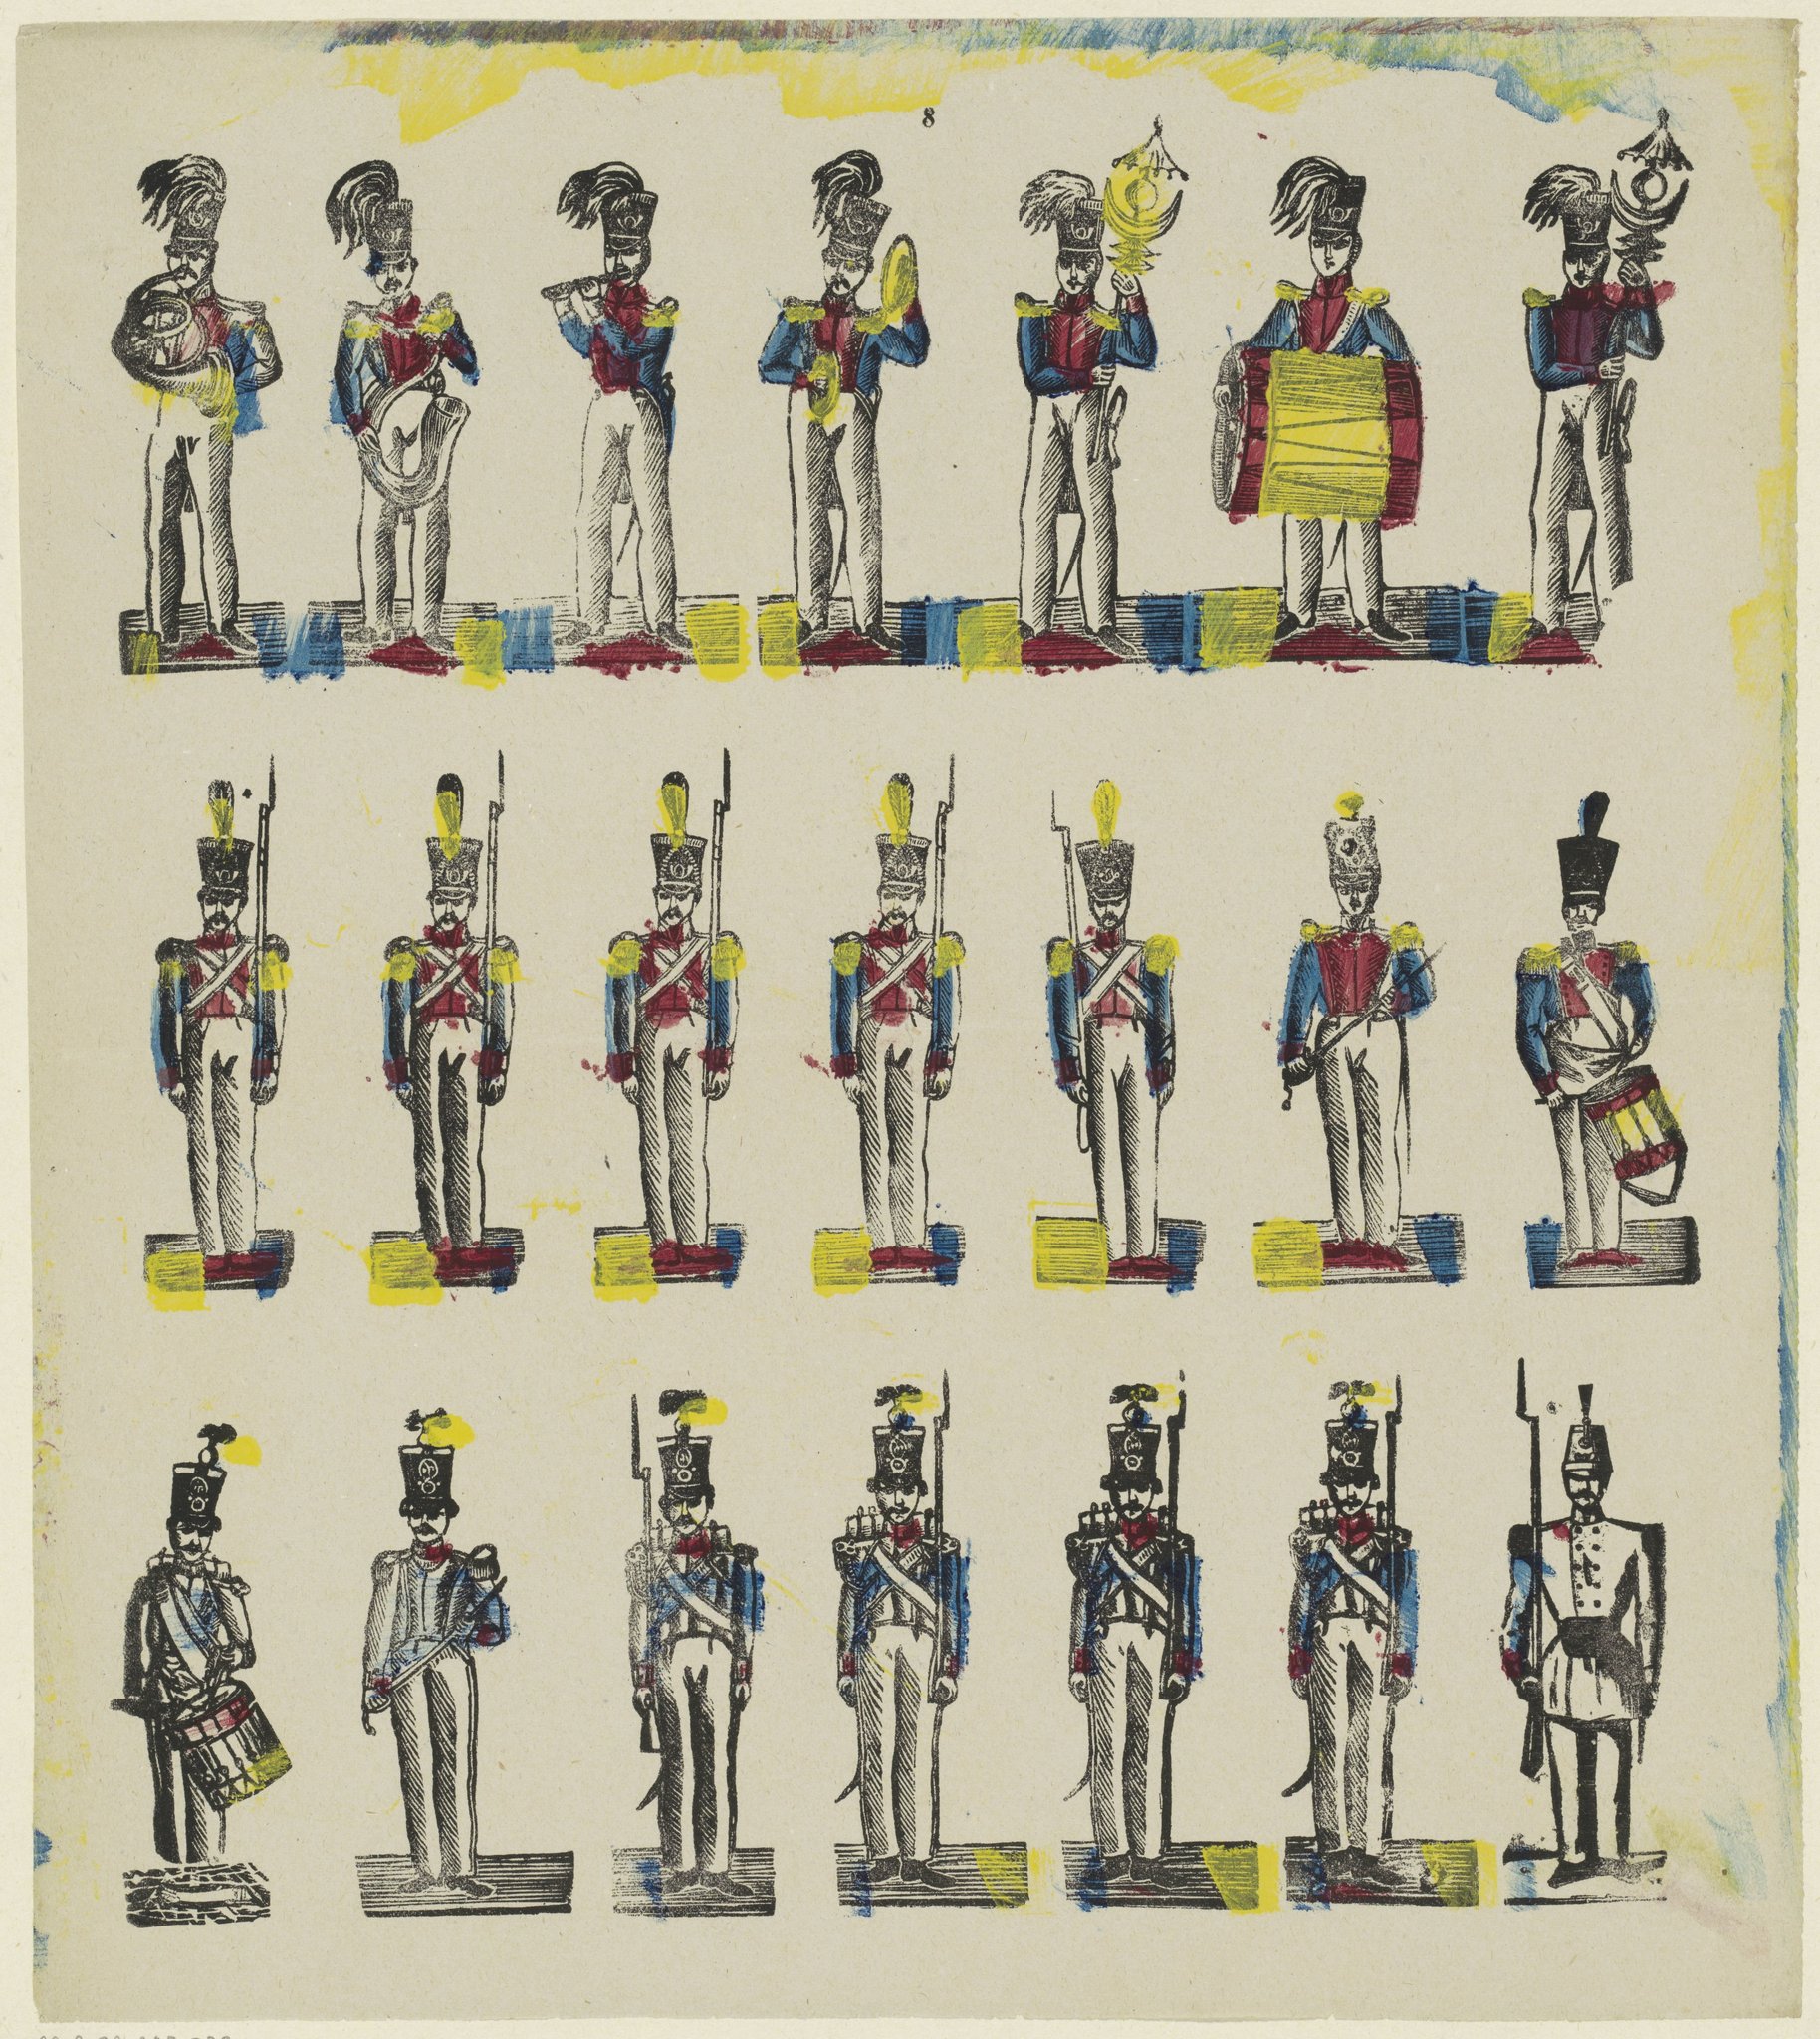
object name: print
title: Militairen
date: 1827-1894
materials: paper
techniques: colour, letterpress printing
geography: schaarbeek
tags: the soldier; the soldier's life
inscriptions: collector's mark: Lugt 2760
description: Blad met 21 voorstellingen van militairen. Genummerd midden boven: 8.